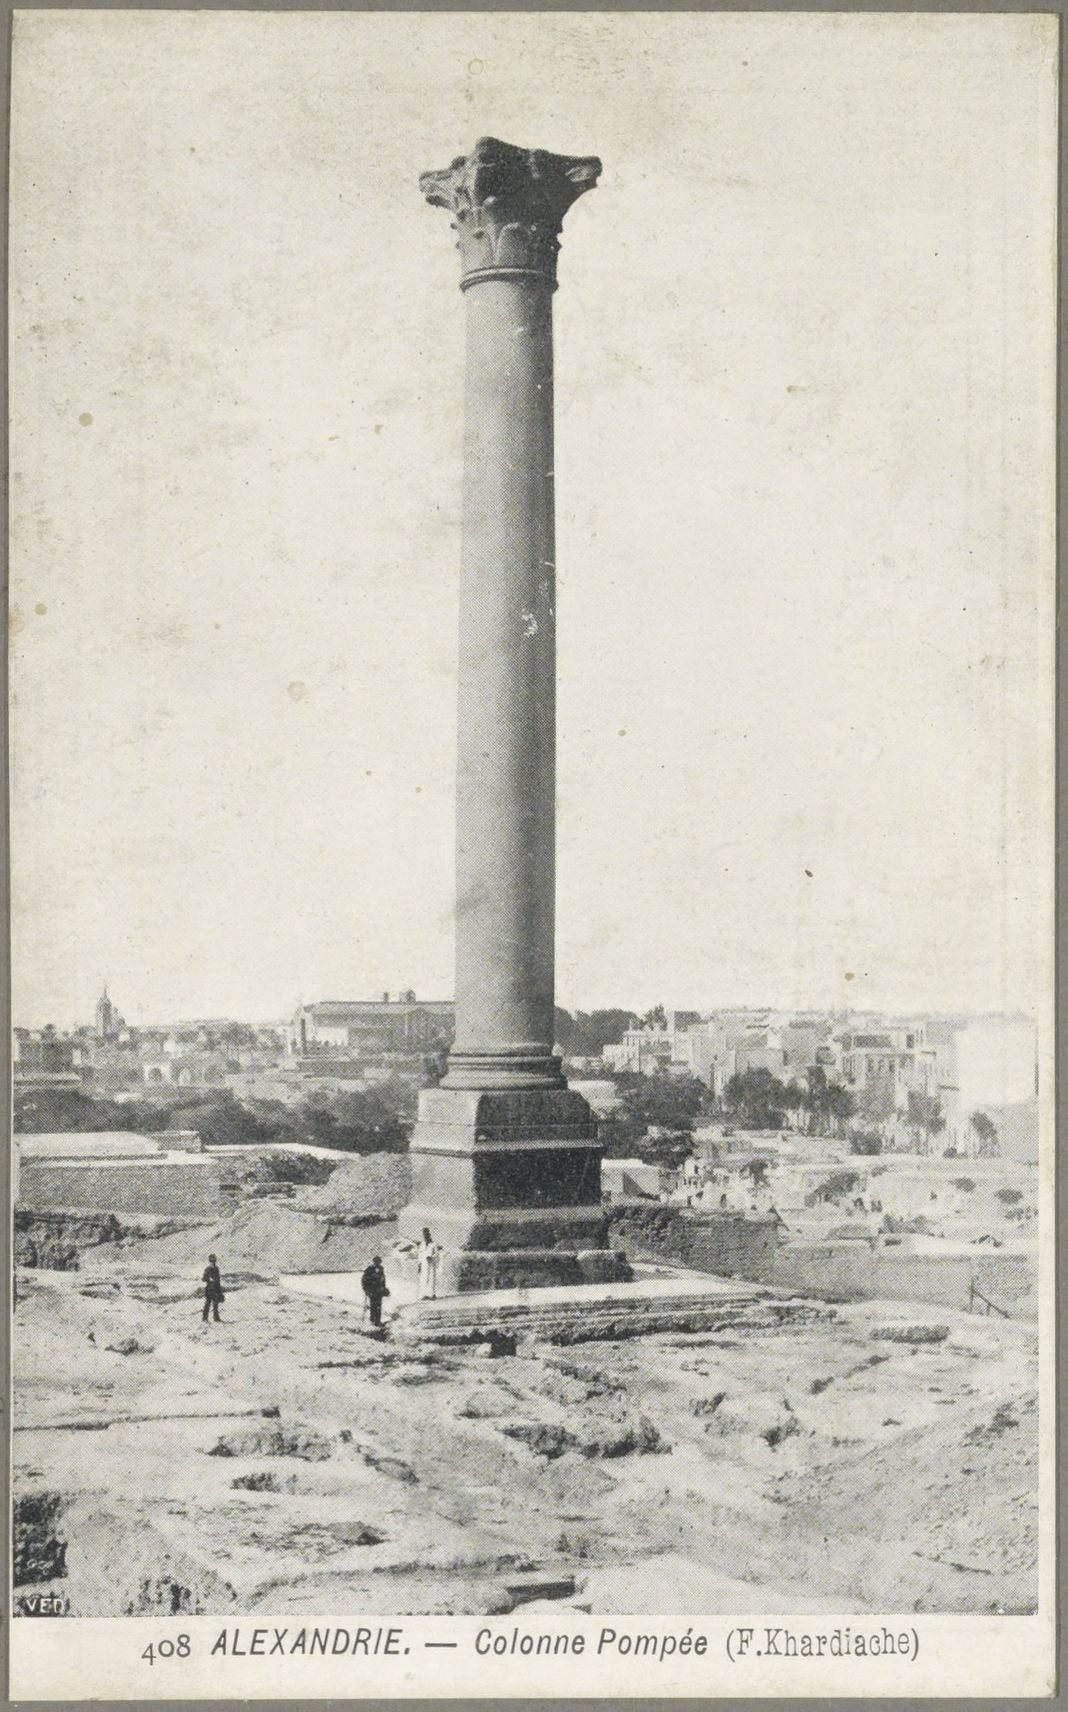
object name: ansichtkaart, prentbriefkaart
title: ALEXANDRIE. - Colonne Pompée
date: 1895-1905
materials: paper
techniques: autotype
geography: alexandria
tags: column, pillar ~ architecture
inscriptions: number: ‘408’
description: Onderdeel van Reisalbum met foto's van bezienswaardigheden in Griekenland en Egypte.